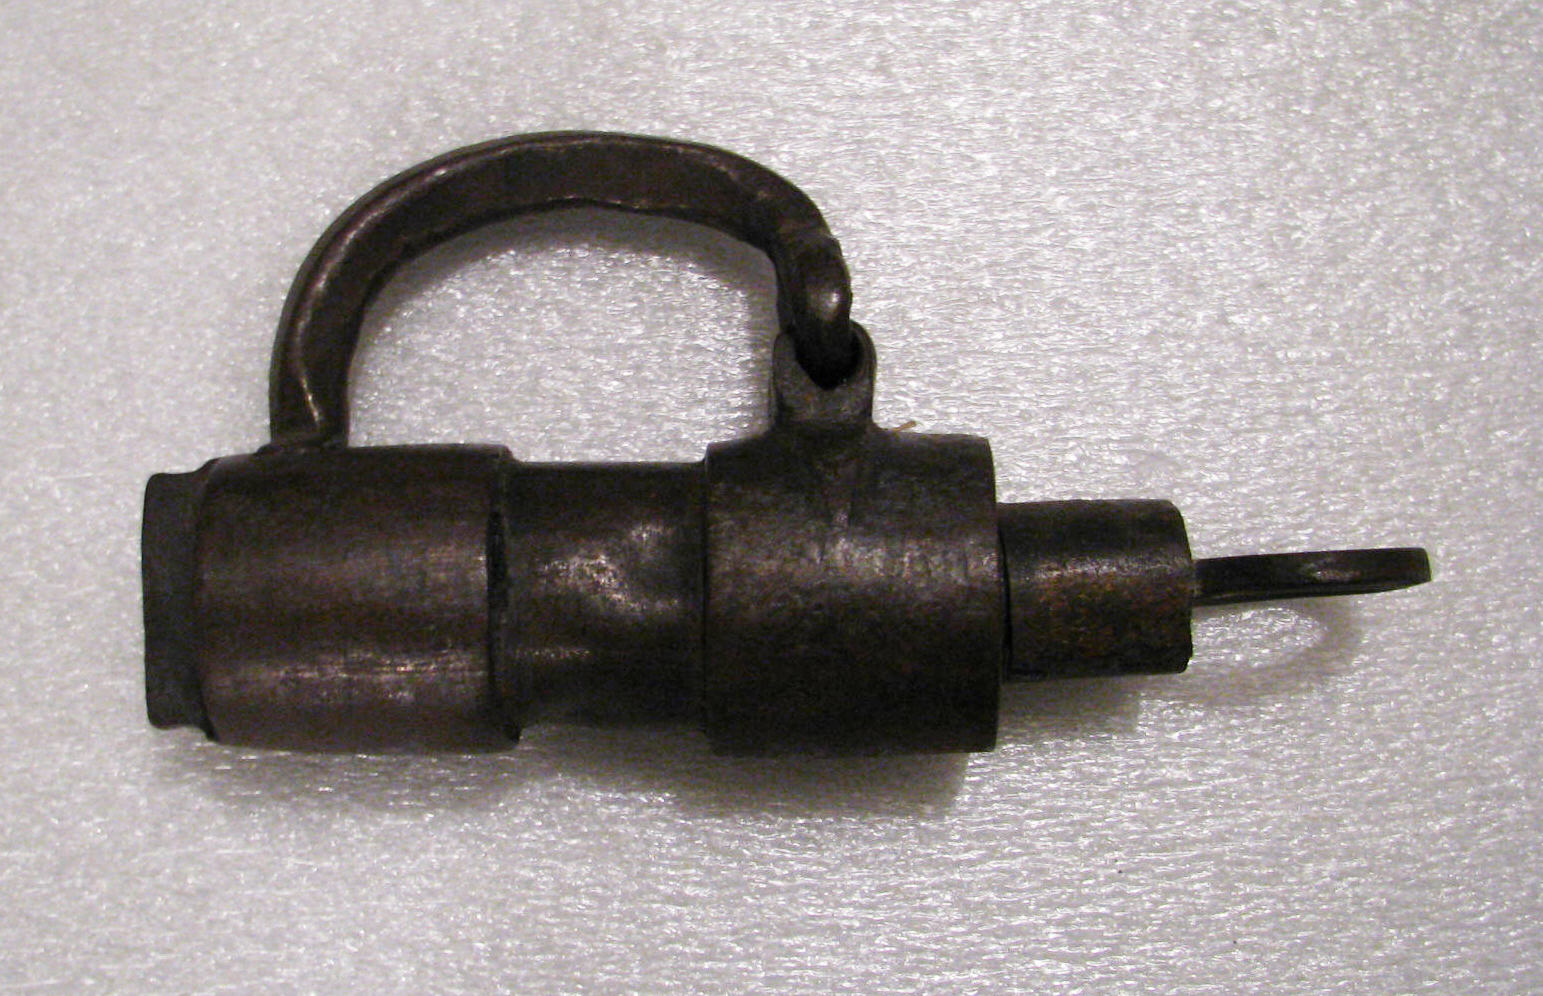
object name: padlock with key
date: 1701-1800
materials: brass, bronze, iron